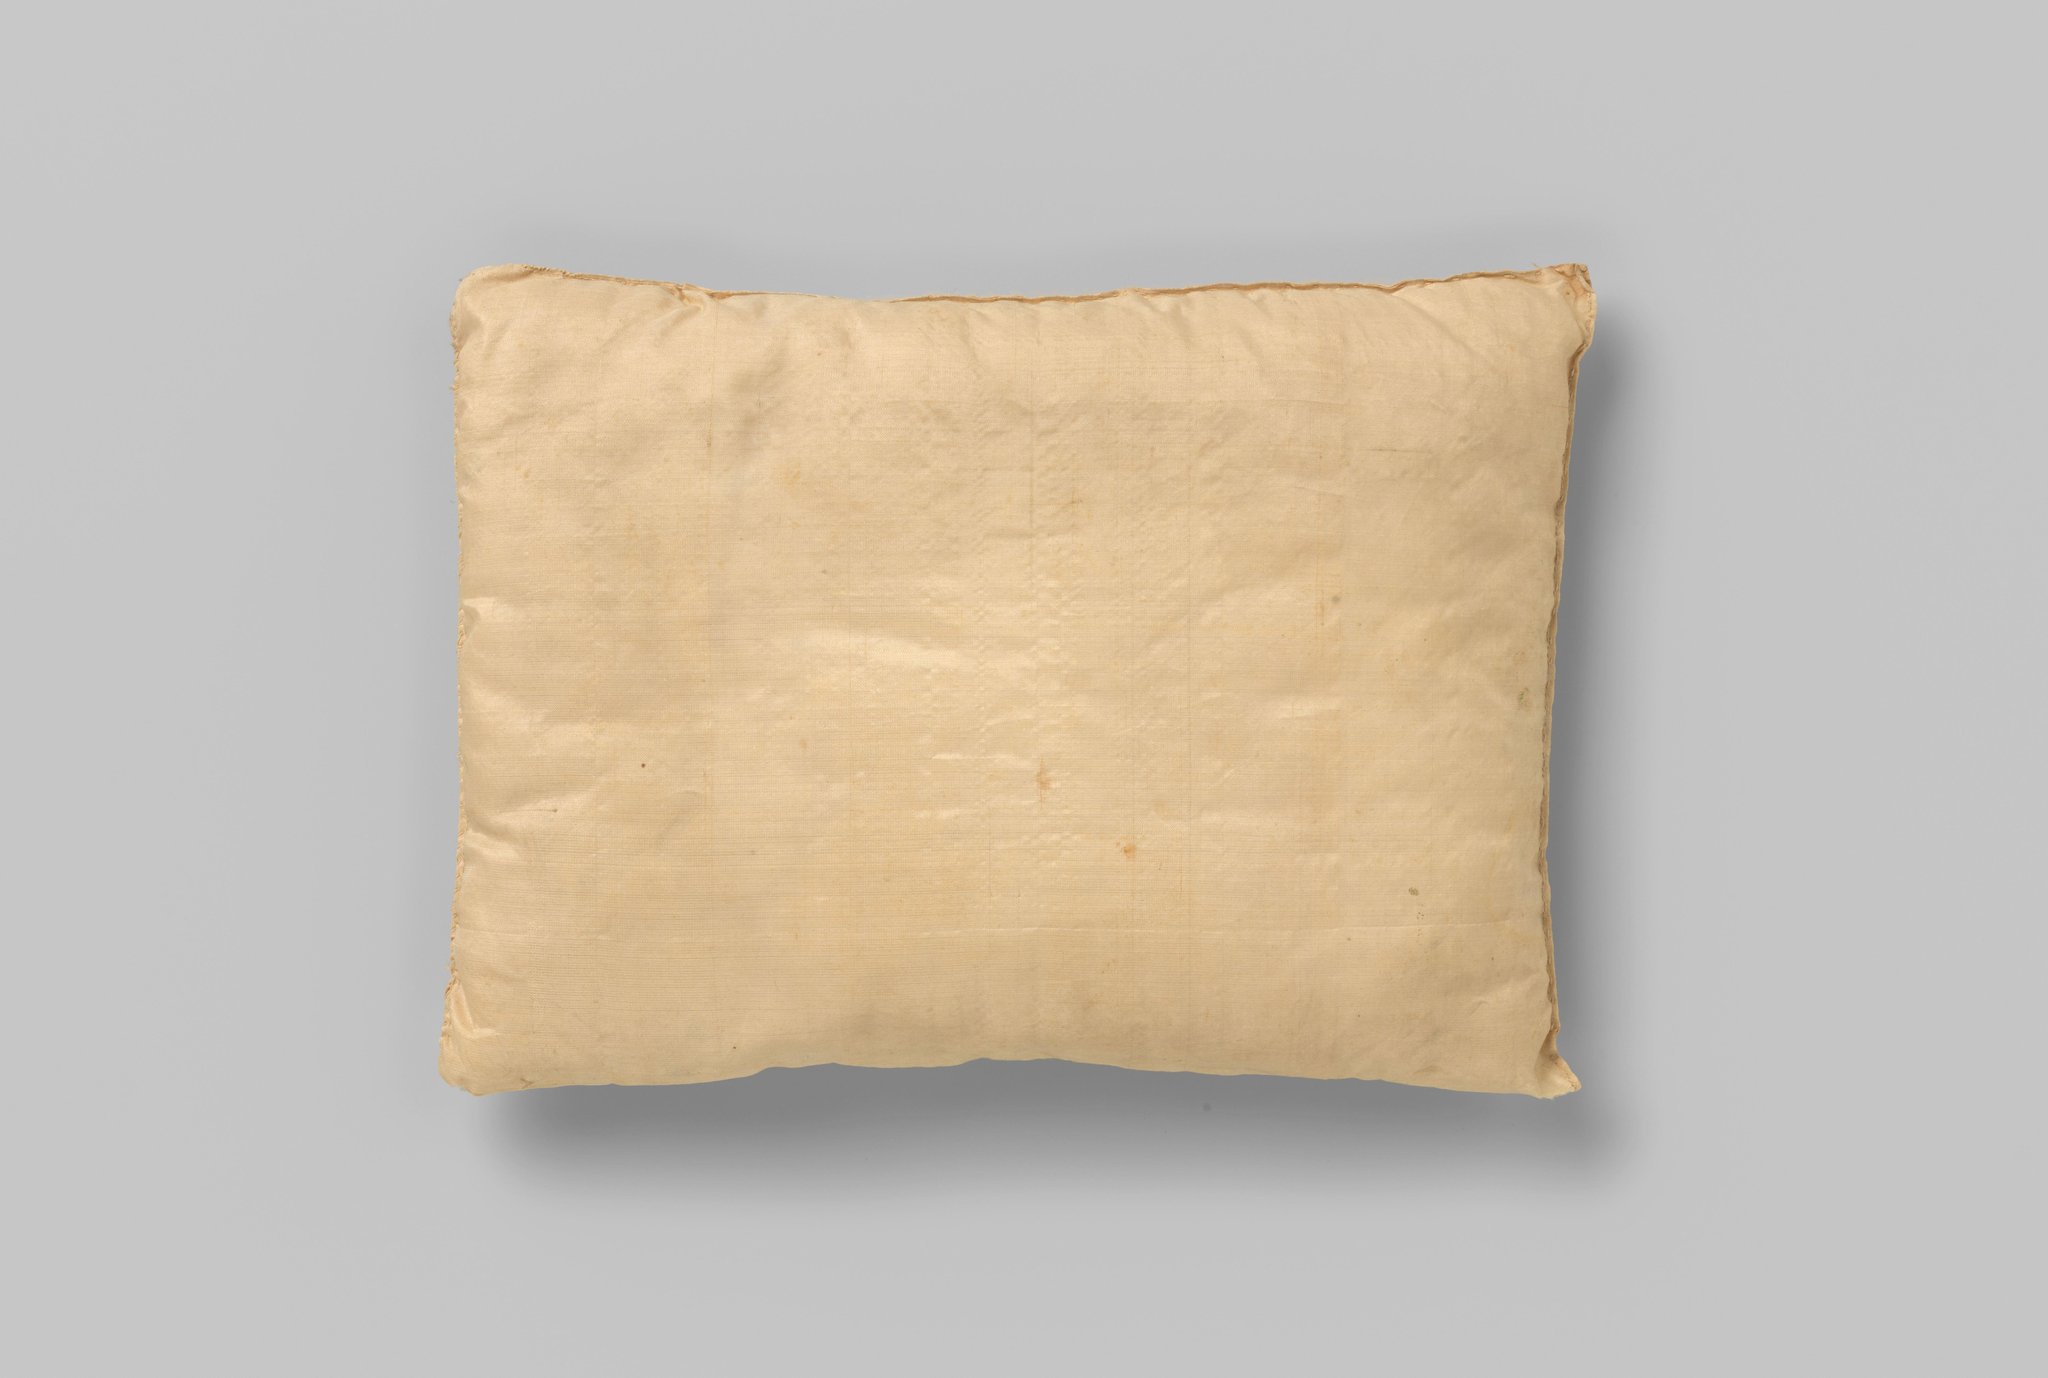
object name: cushion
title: Tea service for two people (tête-à-tête)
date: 1775-1778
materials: silk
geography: vienna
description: Kussen van witte zijde, behorend bij tête-à-tête in lederen etui. (Het servies is door Keizerin Maria Theresia geschonken aan de schilder J.E. Liotard bij zijn vertrek uit Wenen op 5 juni 1778.)